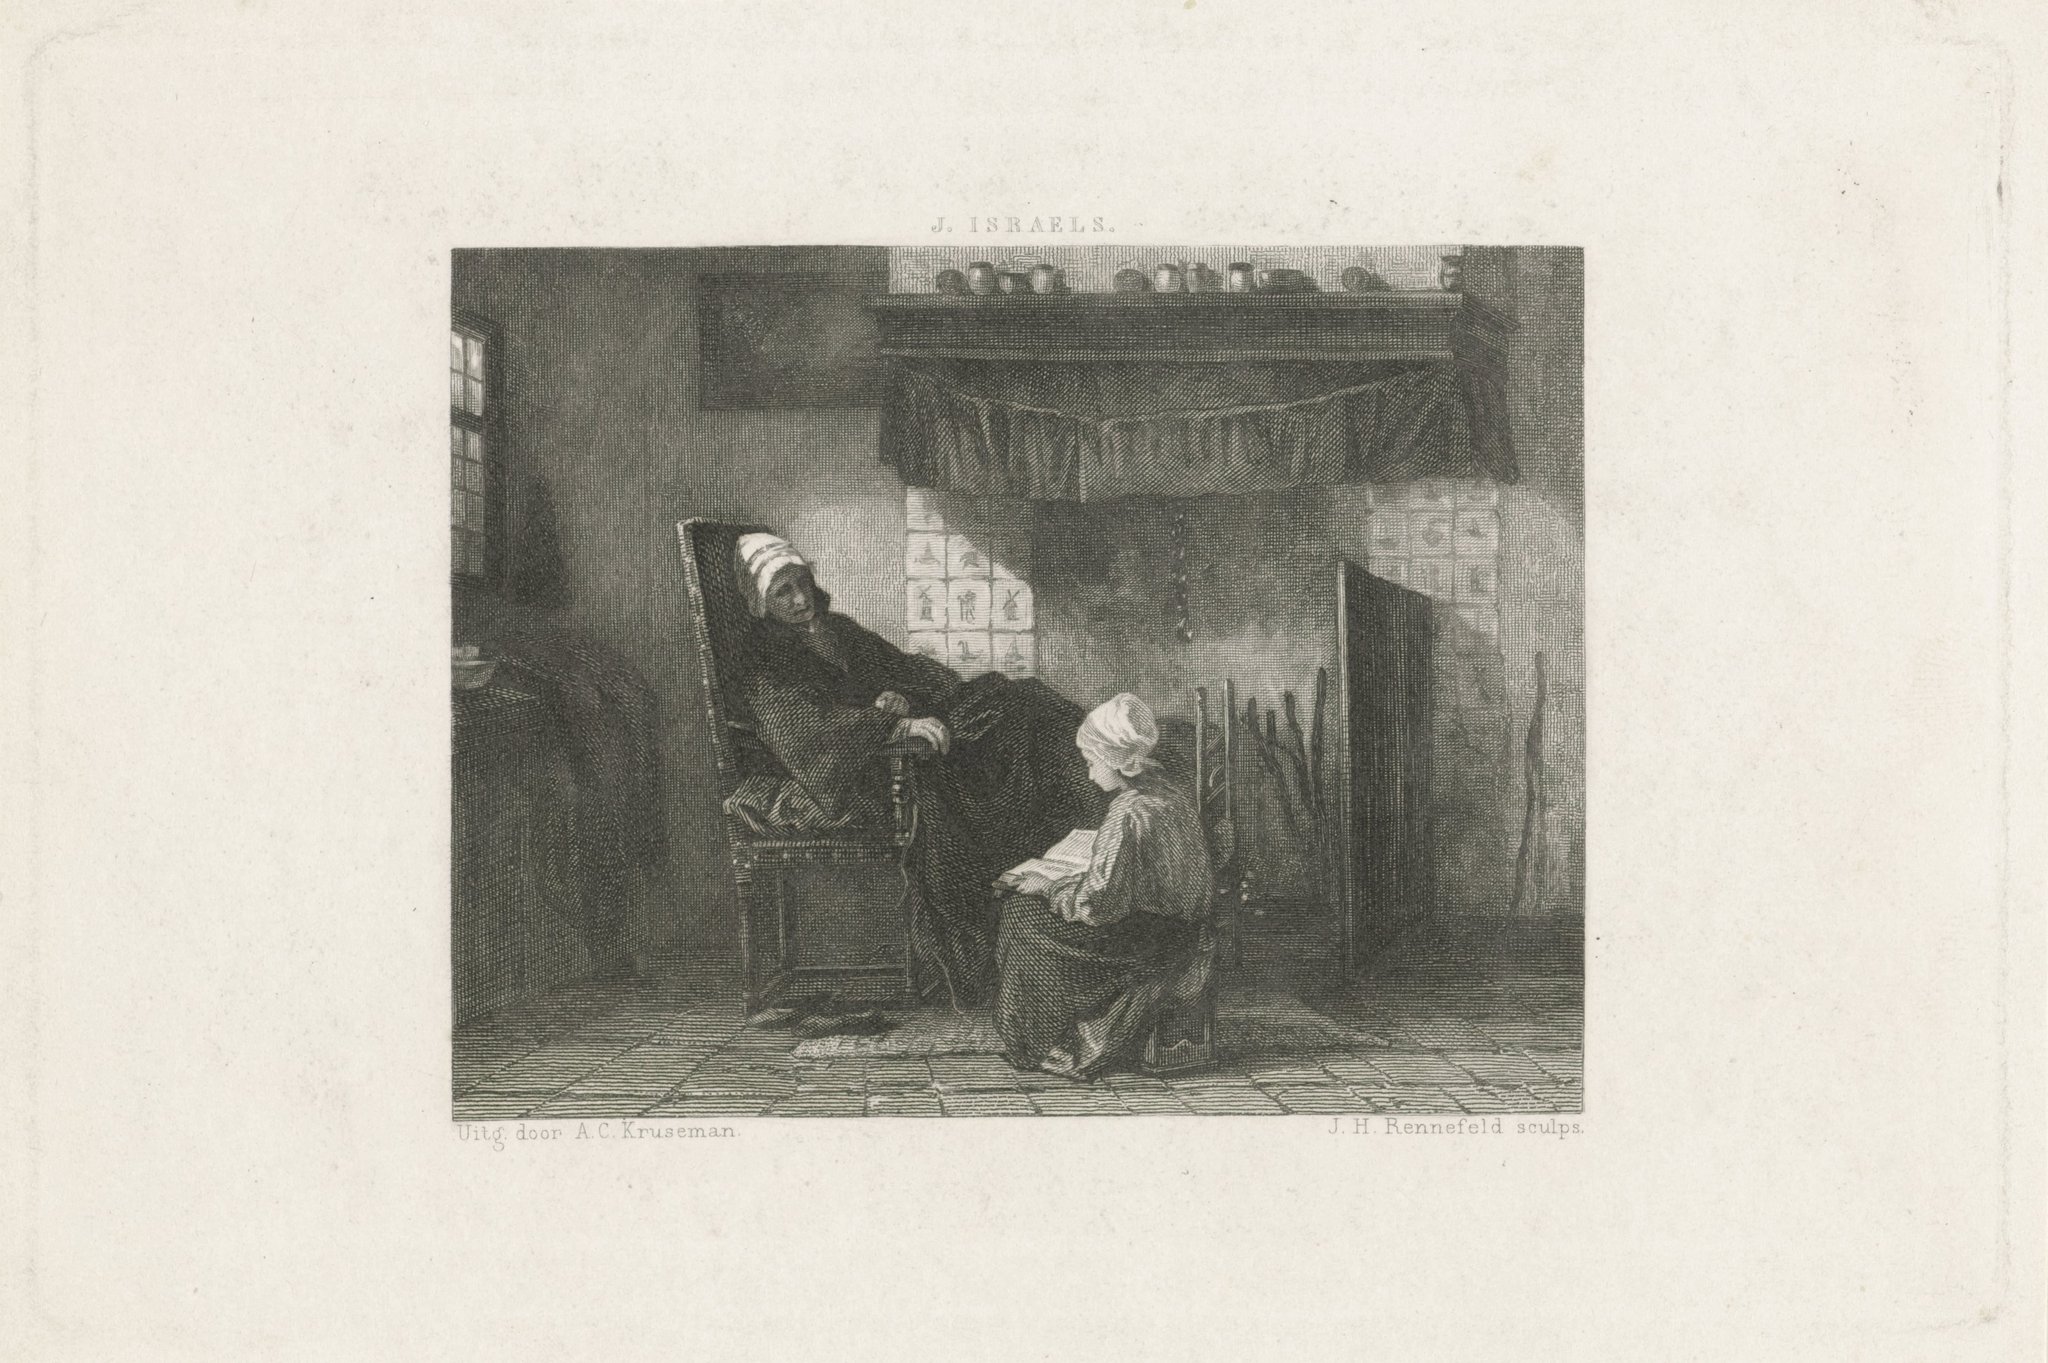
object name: print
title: Oude vrouw voor een haardvuur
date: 1755-1877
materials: paper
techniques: engraving, etching, roulette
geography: amsterdam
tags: reading, foot-stove, open hearth, fire-place, old woman, chair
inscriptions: collector's mark: Lugt 2228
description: In een vertrek zit een oude zieke vrouw in een armstoel voor het haardvuur. Naast haar zit een kind op een stoof (voor) te lezen uit een boek.